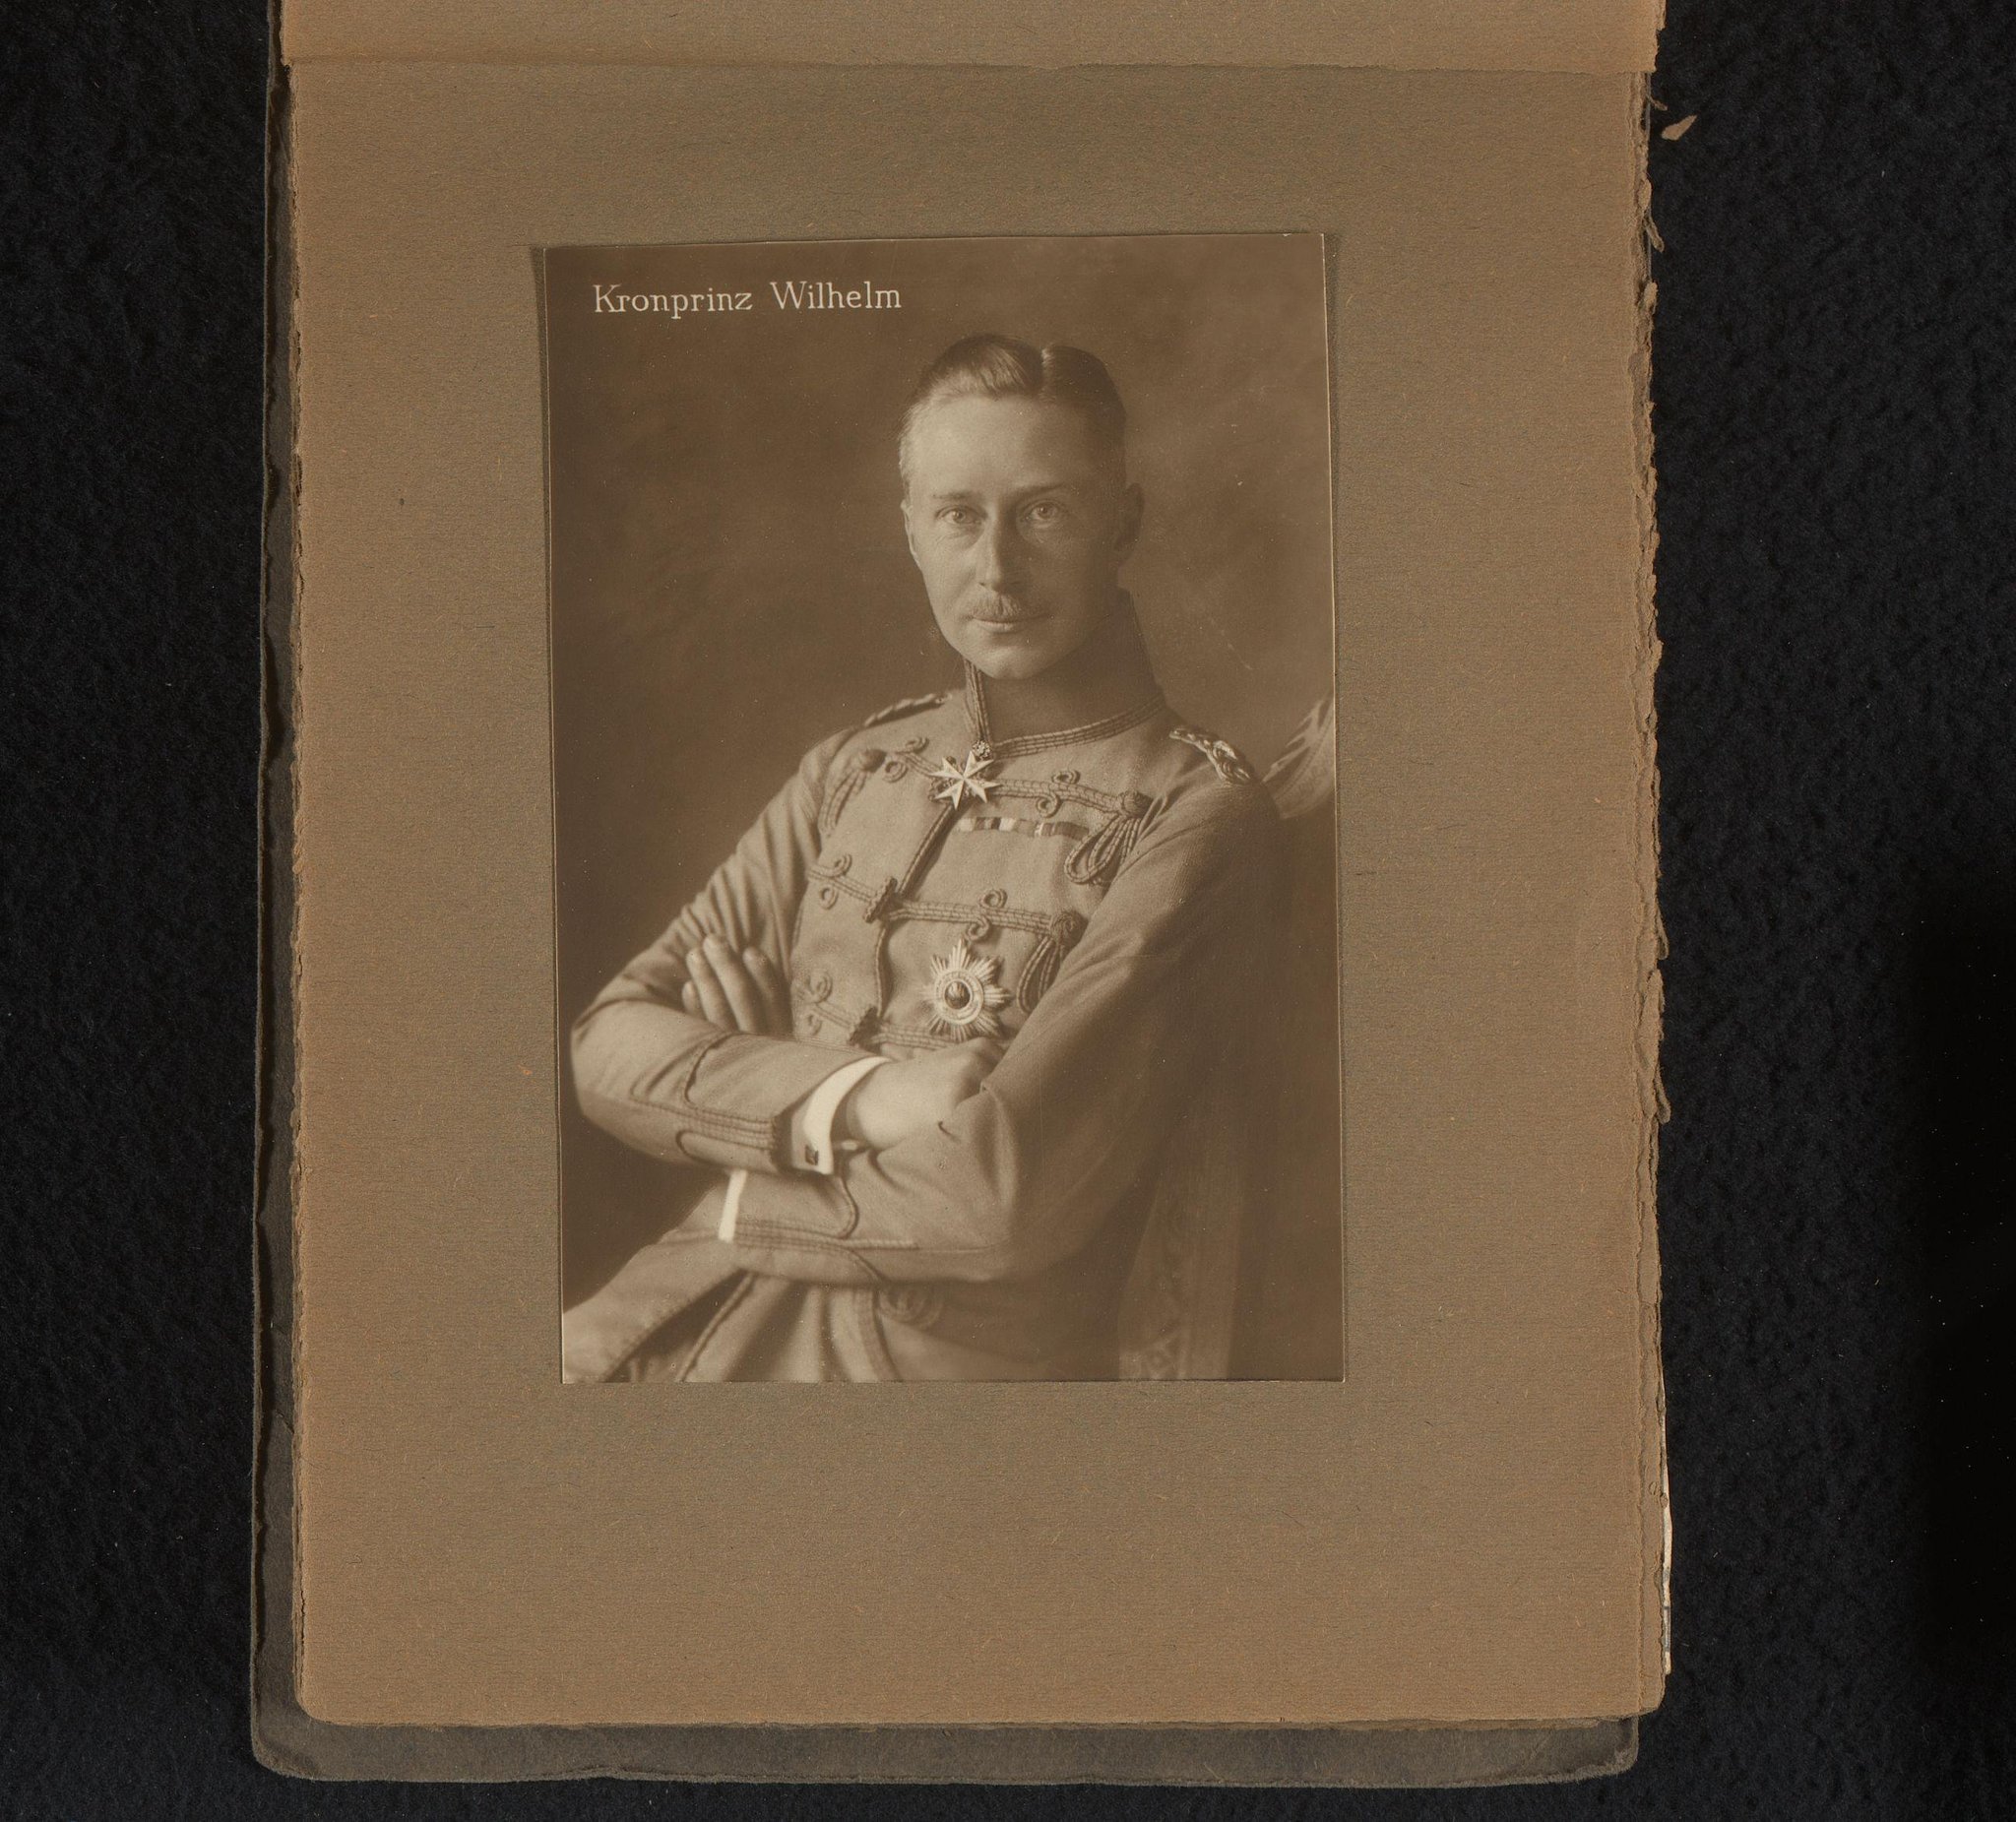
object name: photograph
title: Kronprinz Wilhelm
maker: Anonymous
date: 1905-1910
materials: paper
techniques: gelatin silver print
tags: historical persons, crown prince